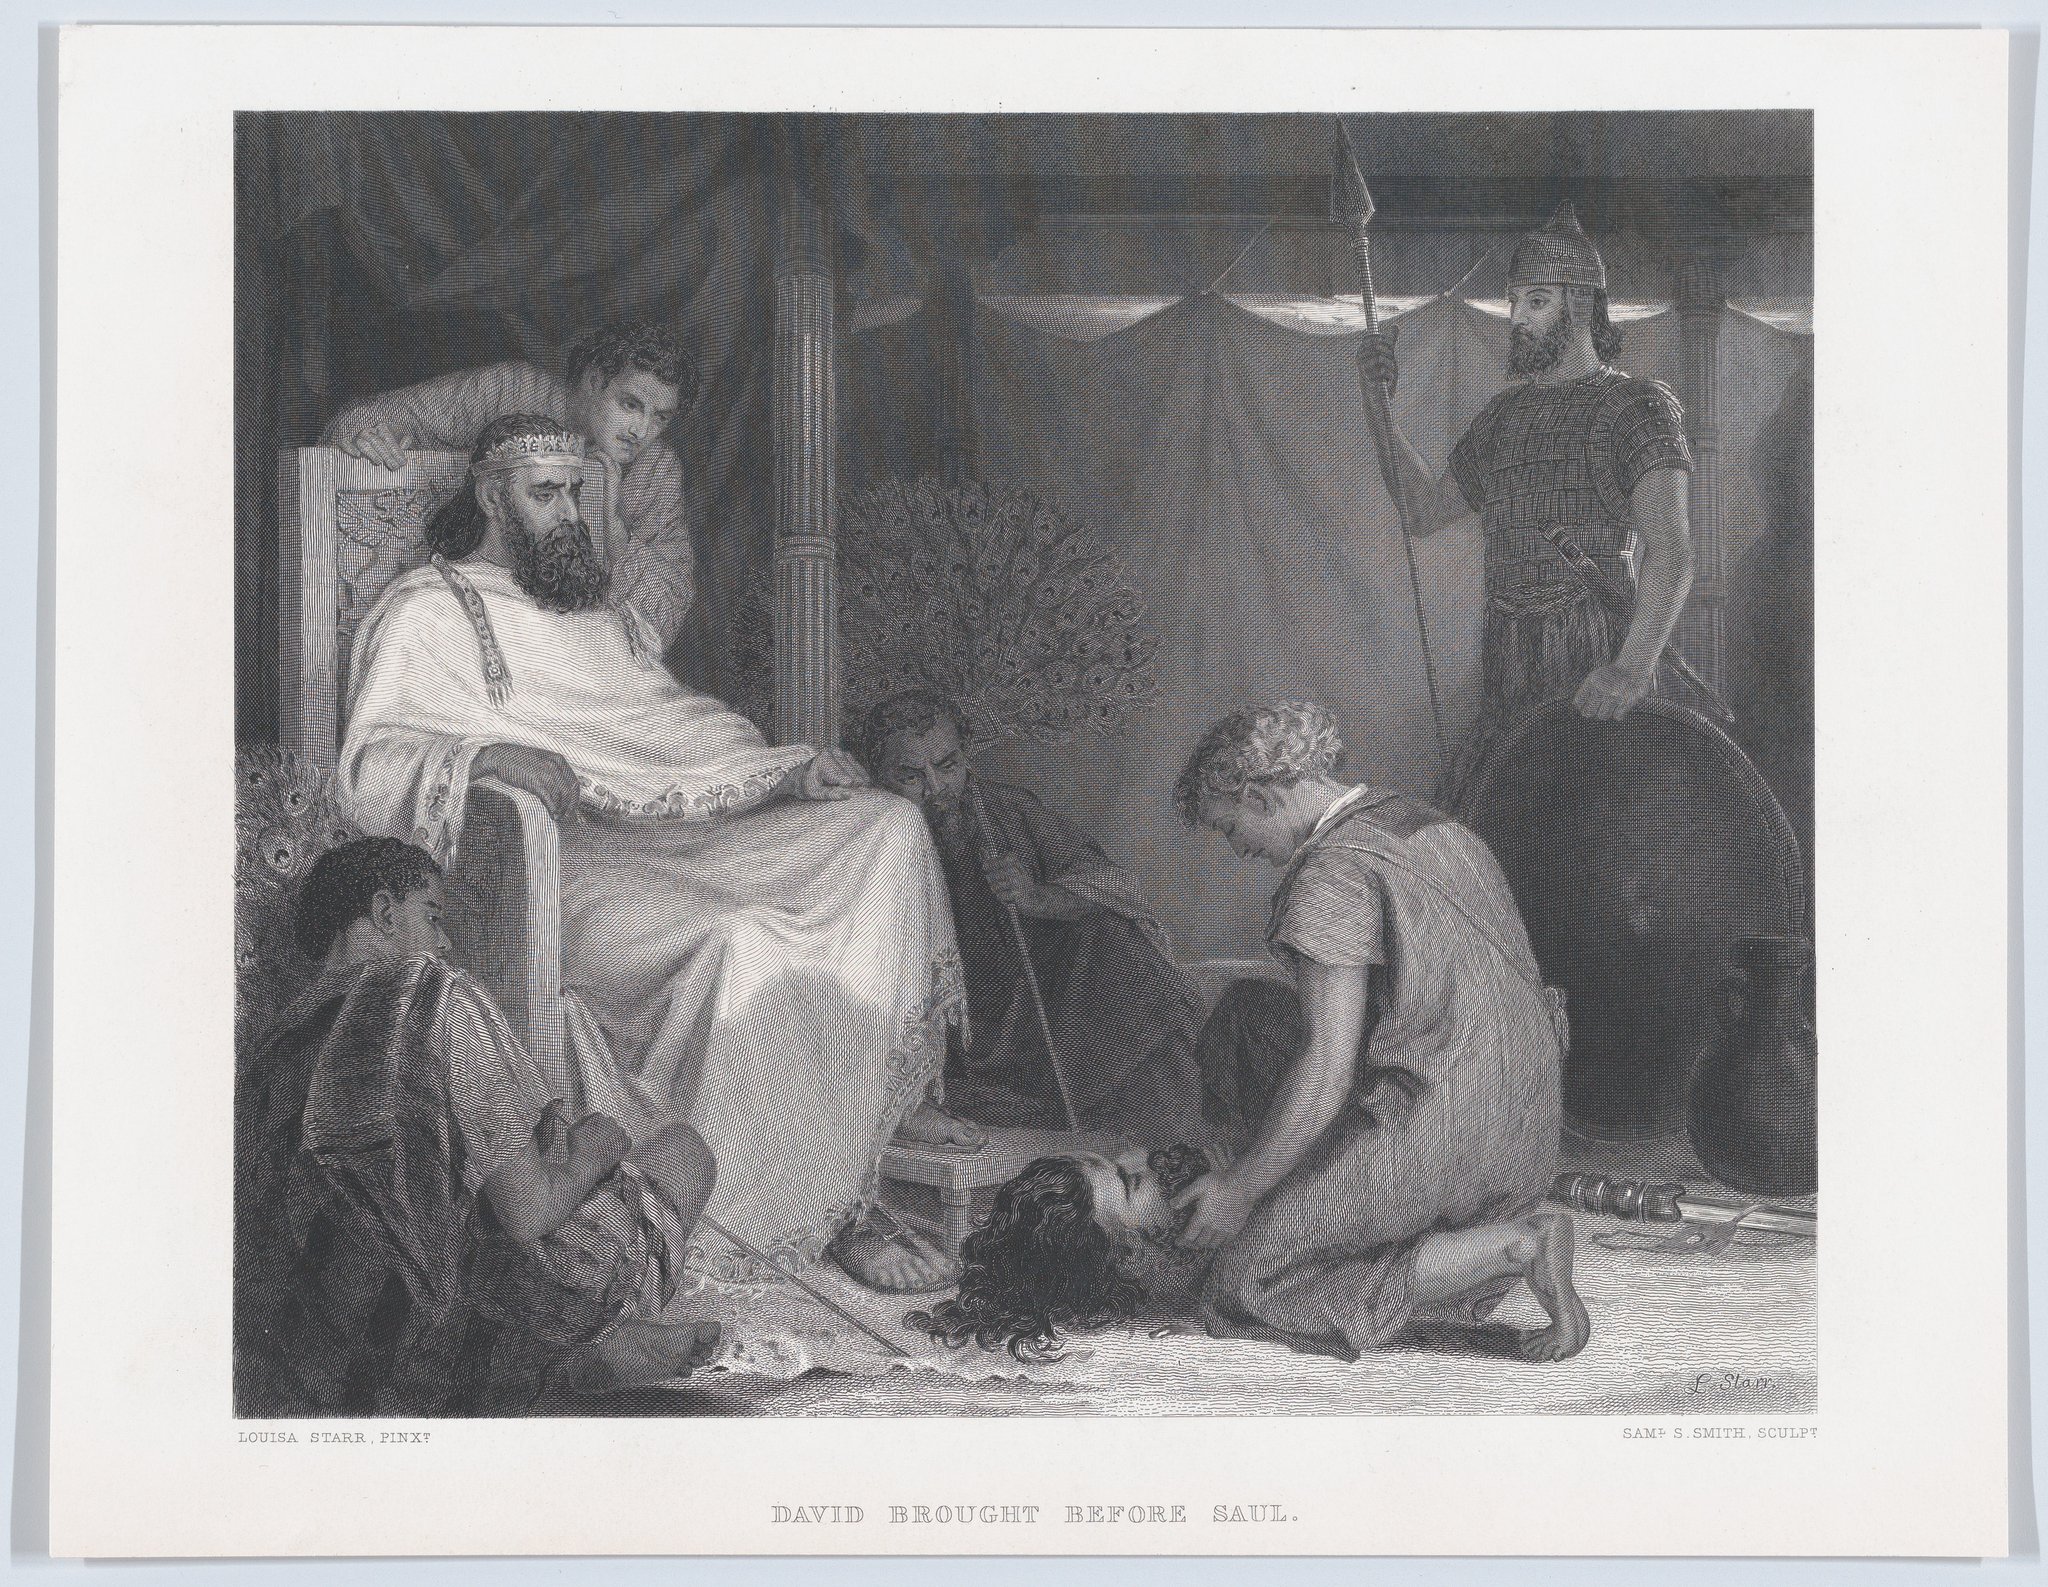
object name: print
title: David Brought Before Saul, from "The Art Journal," opposite p. 100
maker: samuel s. smith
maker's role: engraver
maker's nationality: british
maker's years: 1810-1879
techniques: engraving, etching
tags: kings,heads,men,women,david